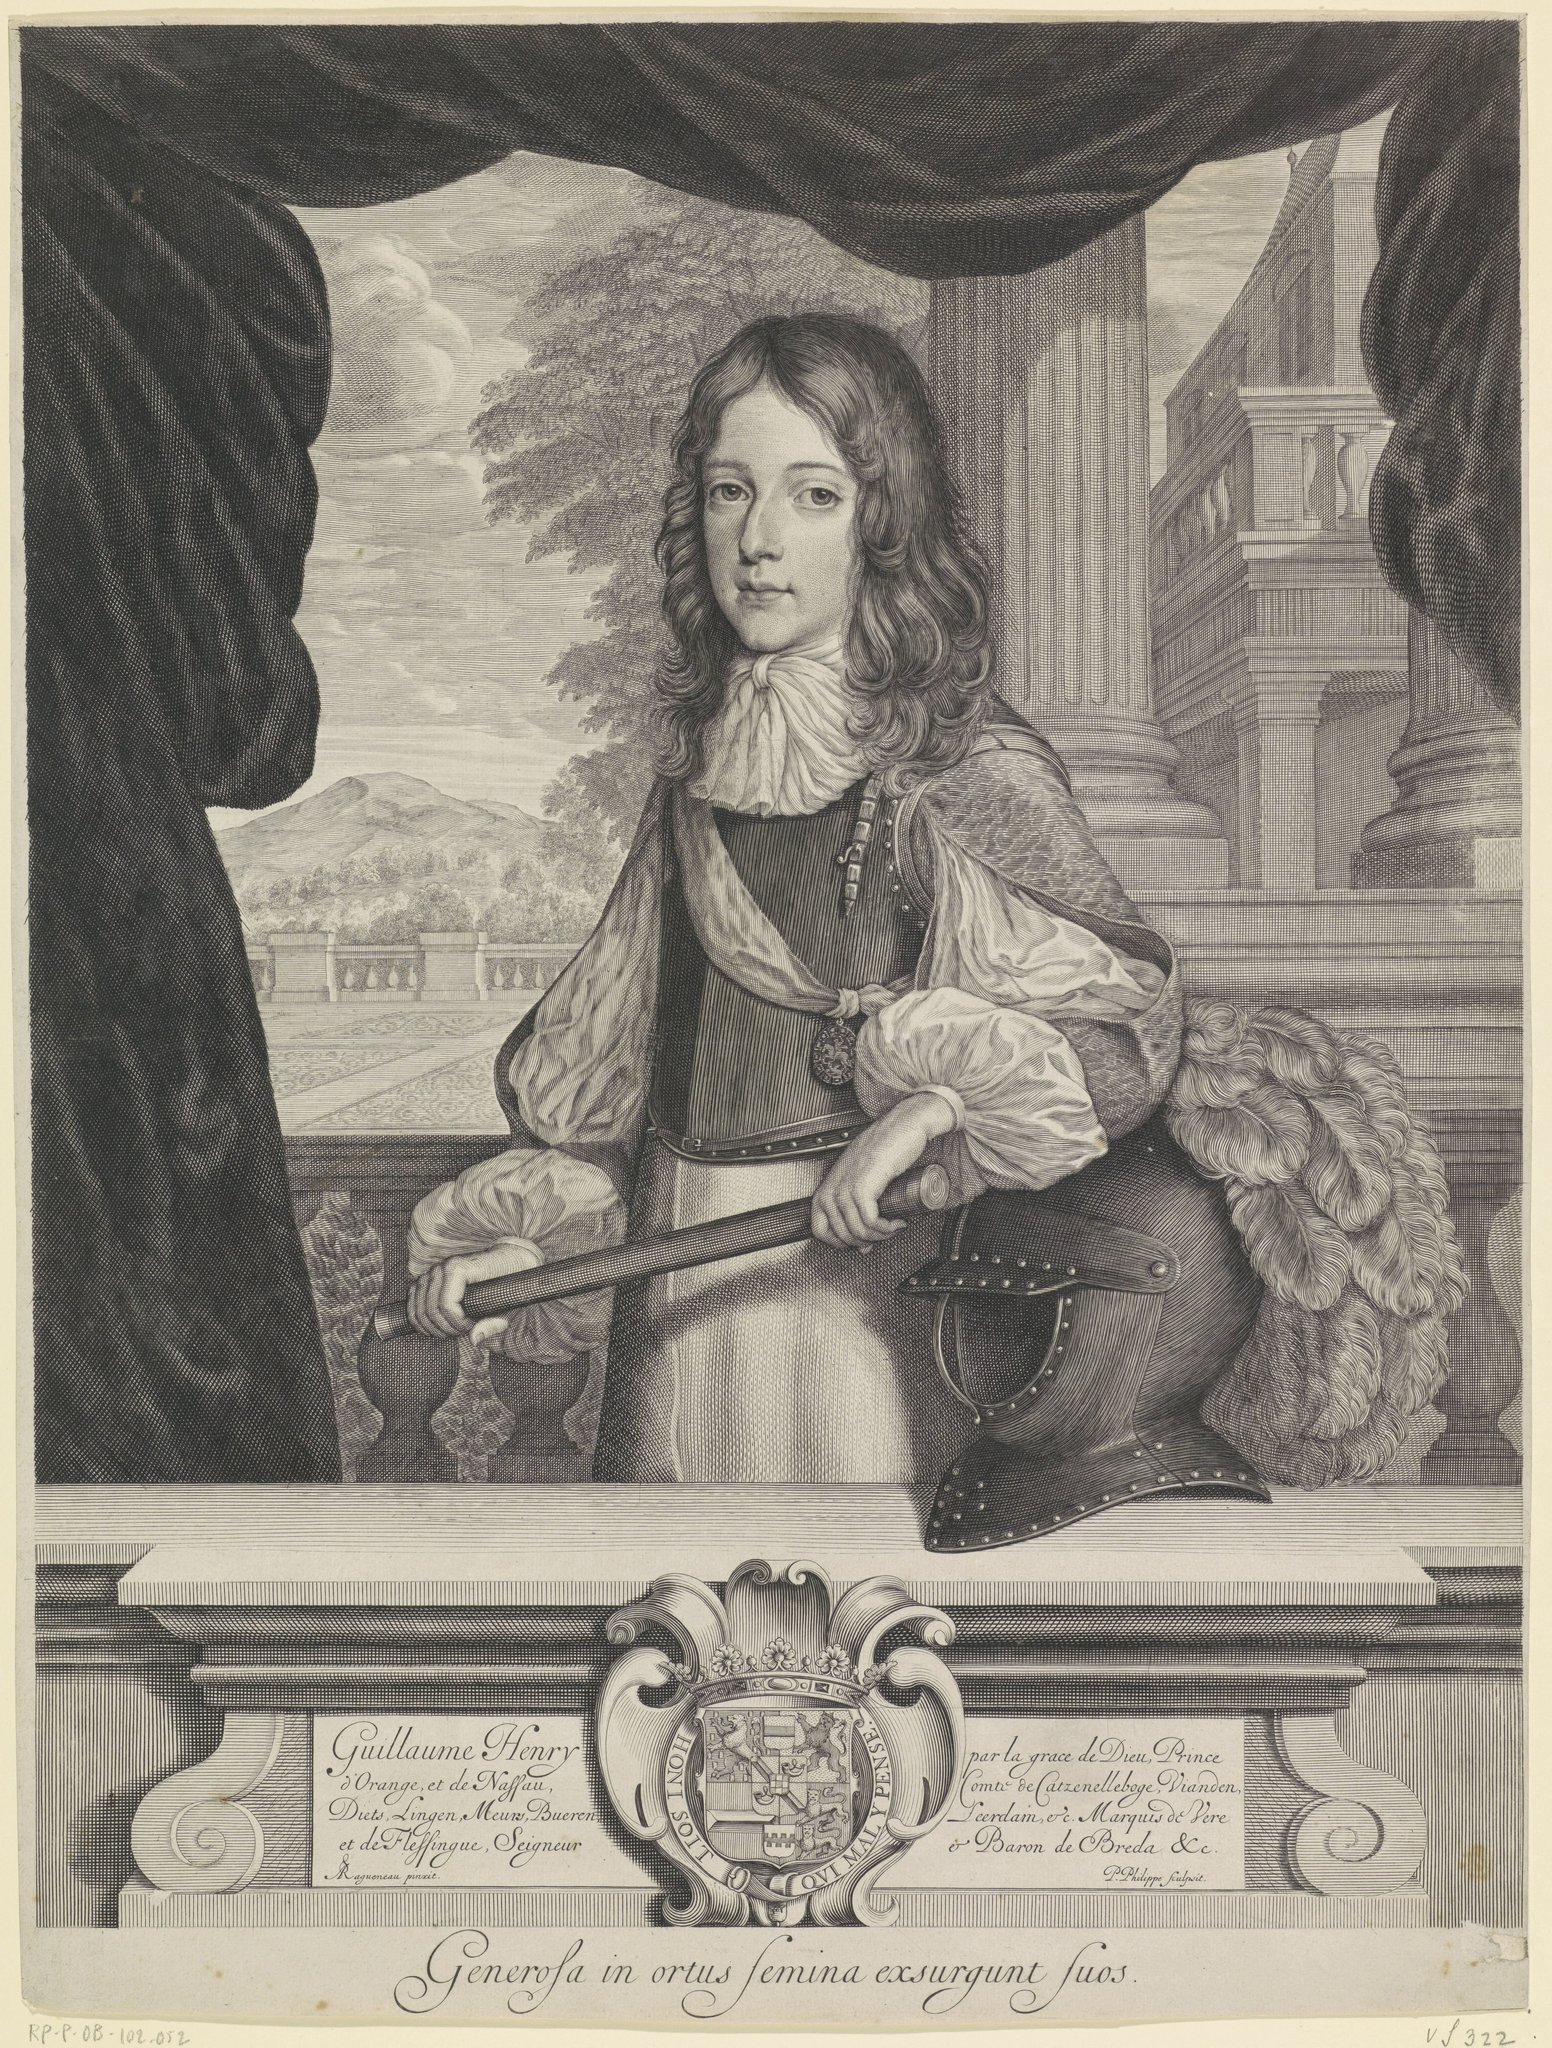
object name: print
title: Portret van Willem III, prins van Oranje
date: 1660-1702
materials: paper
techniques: engraving, etching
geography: the hague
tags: william iii (prince of orange and king of england, scotland, and ireland), knighthood order (garter) - insignia of a knighthood order, e.g.: badge, chain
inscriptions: collector's mark: Lugt 573, collector's mark: Lugt 12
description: Portret van Willem III. Hij staat achter een balustrade en leunt op een helm. In zijn handen een commandostaf. Op de achtergrond een tuin. Midden onder zijn wapen met een kroon, gedecoreerd met de Kousenband en het devies van de Orde van de Kousenband. In een kader zijn naam en titels in het Frans. In de ondermarge een regel Latijnse tekst.